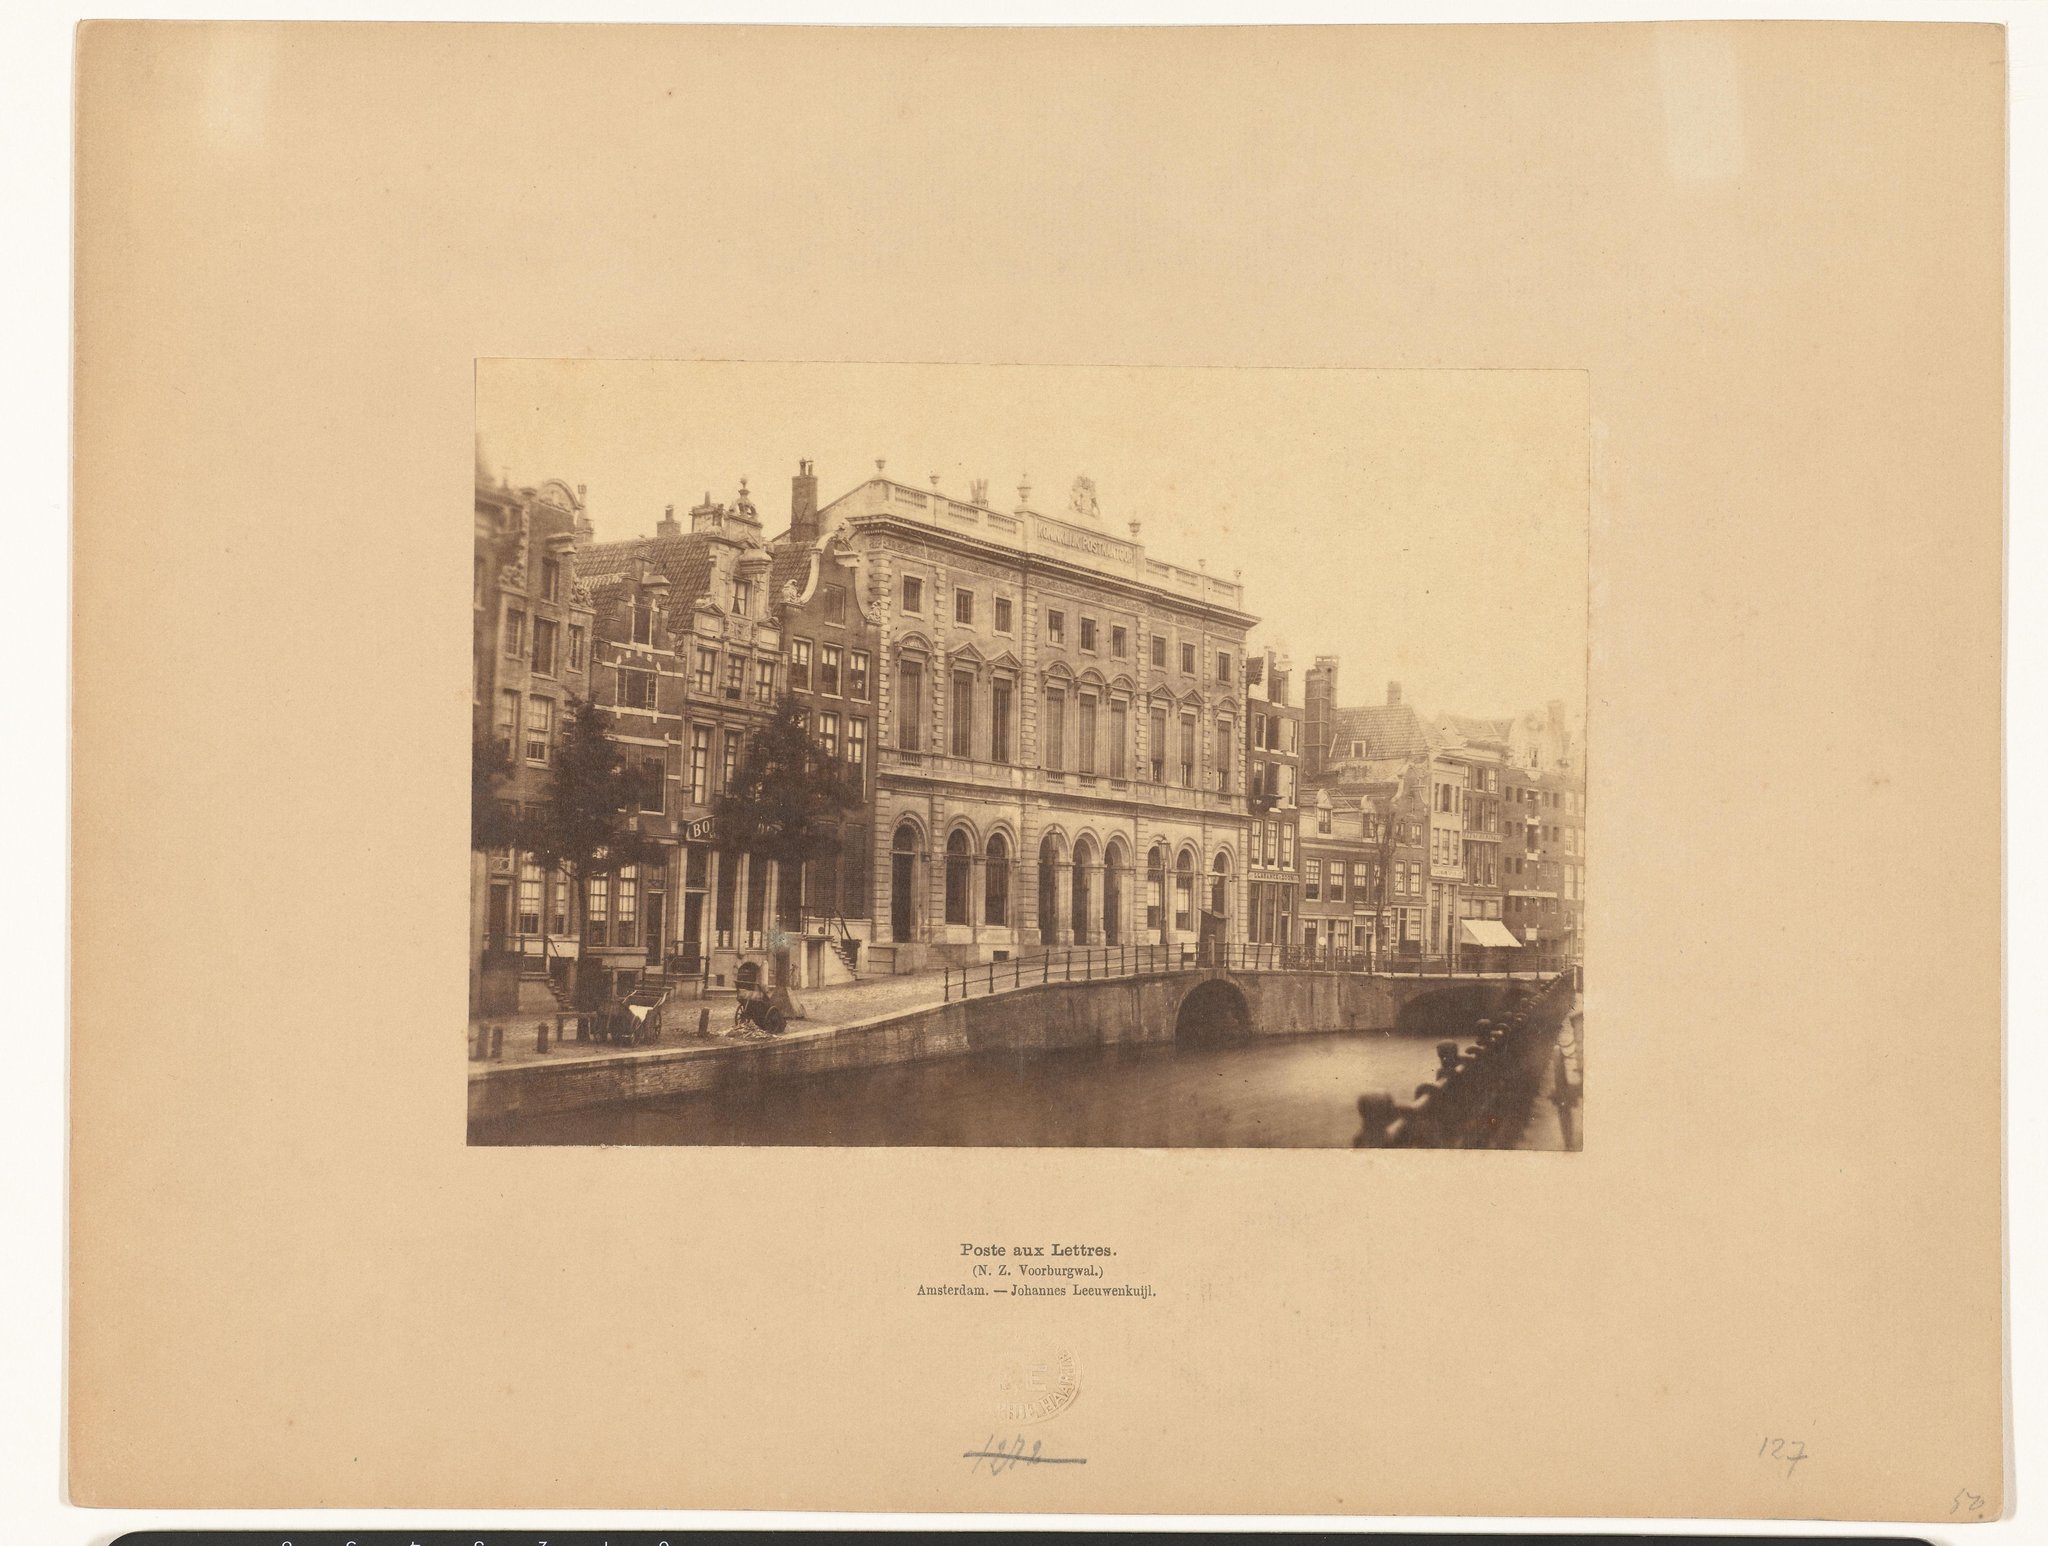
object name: photograph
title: Het Postkantoor aan de Nieuwezijds Voorburgwal te Amsterdam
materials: cardboard, paper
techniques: albumen print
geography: haarlem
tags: post-office, canal